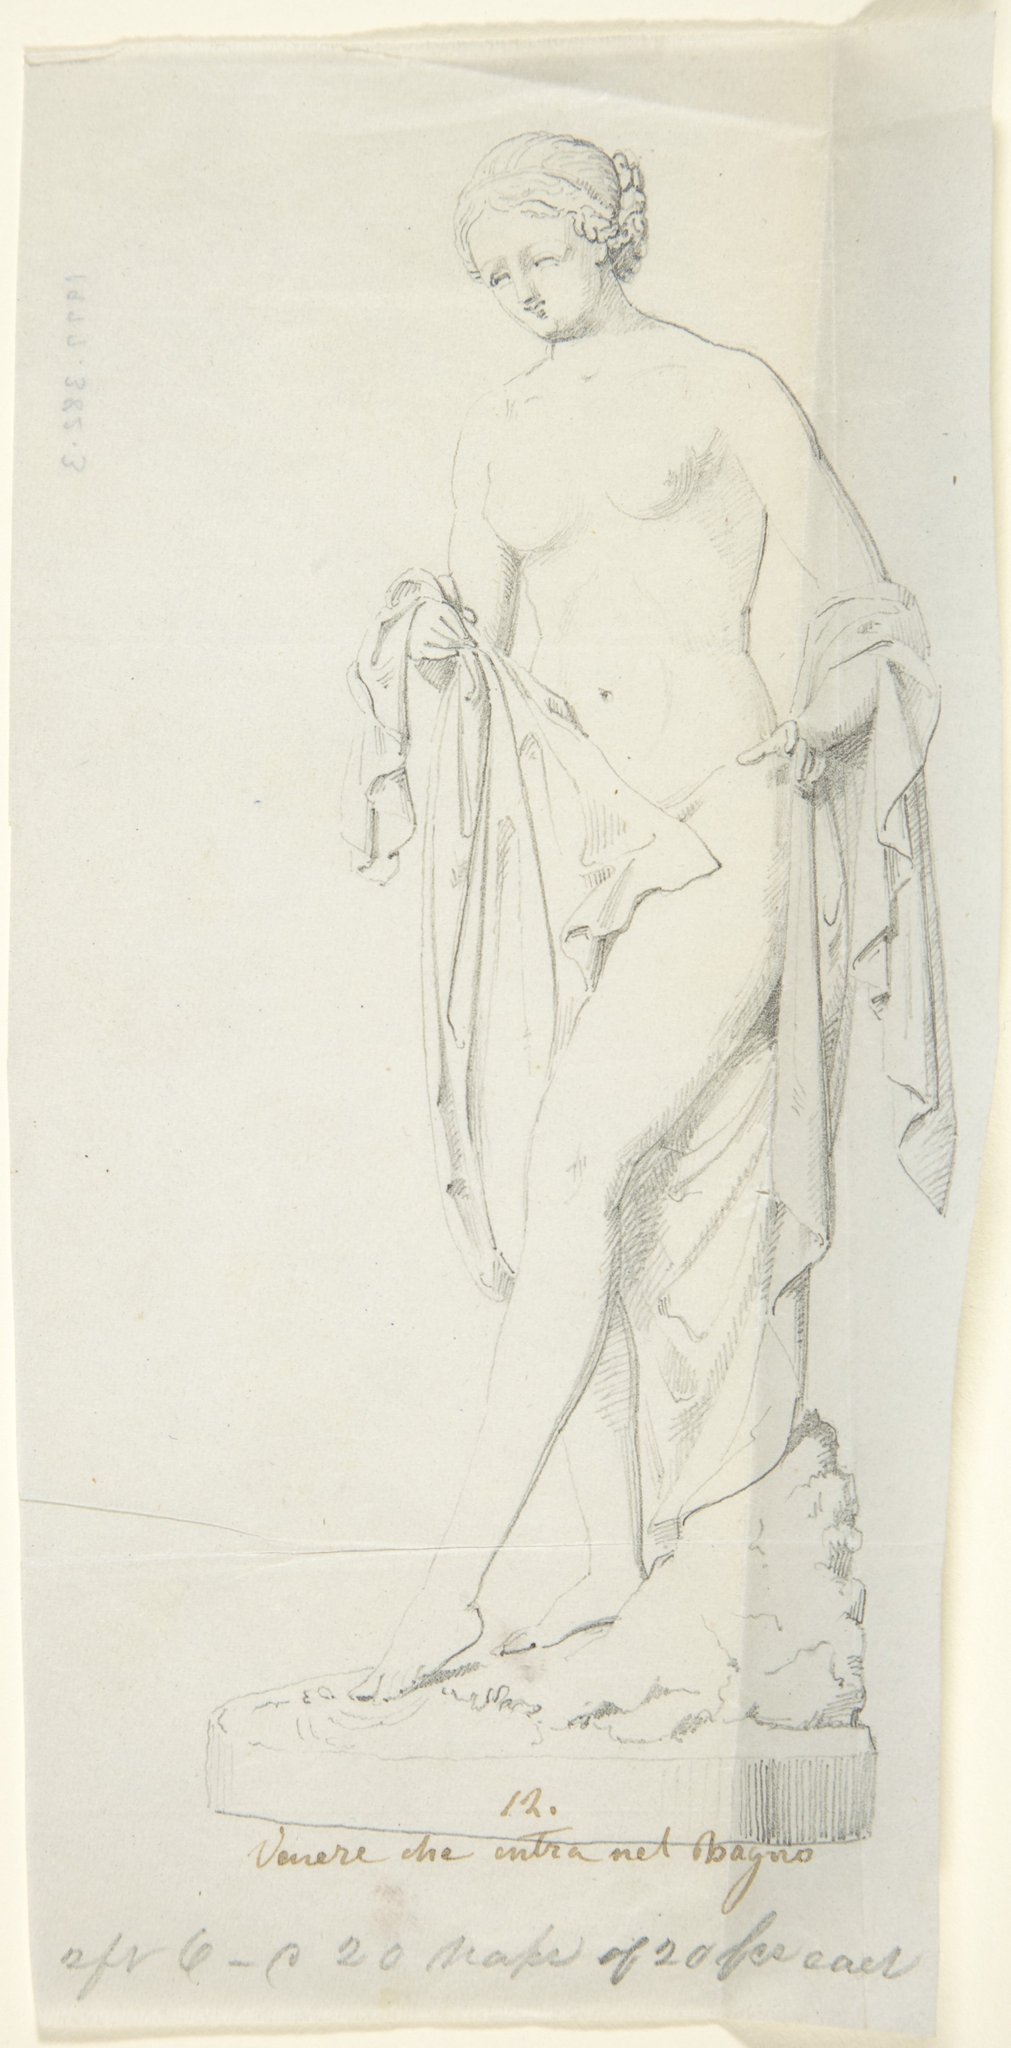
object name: drawing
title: Sketch of a statue: Venus Entering the Bath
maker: john gibson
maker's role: artist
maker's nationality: british, born wales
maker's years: 1790-1866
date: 1850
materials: graphite, ink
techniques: pen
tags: venus